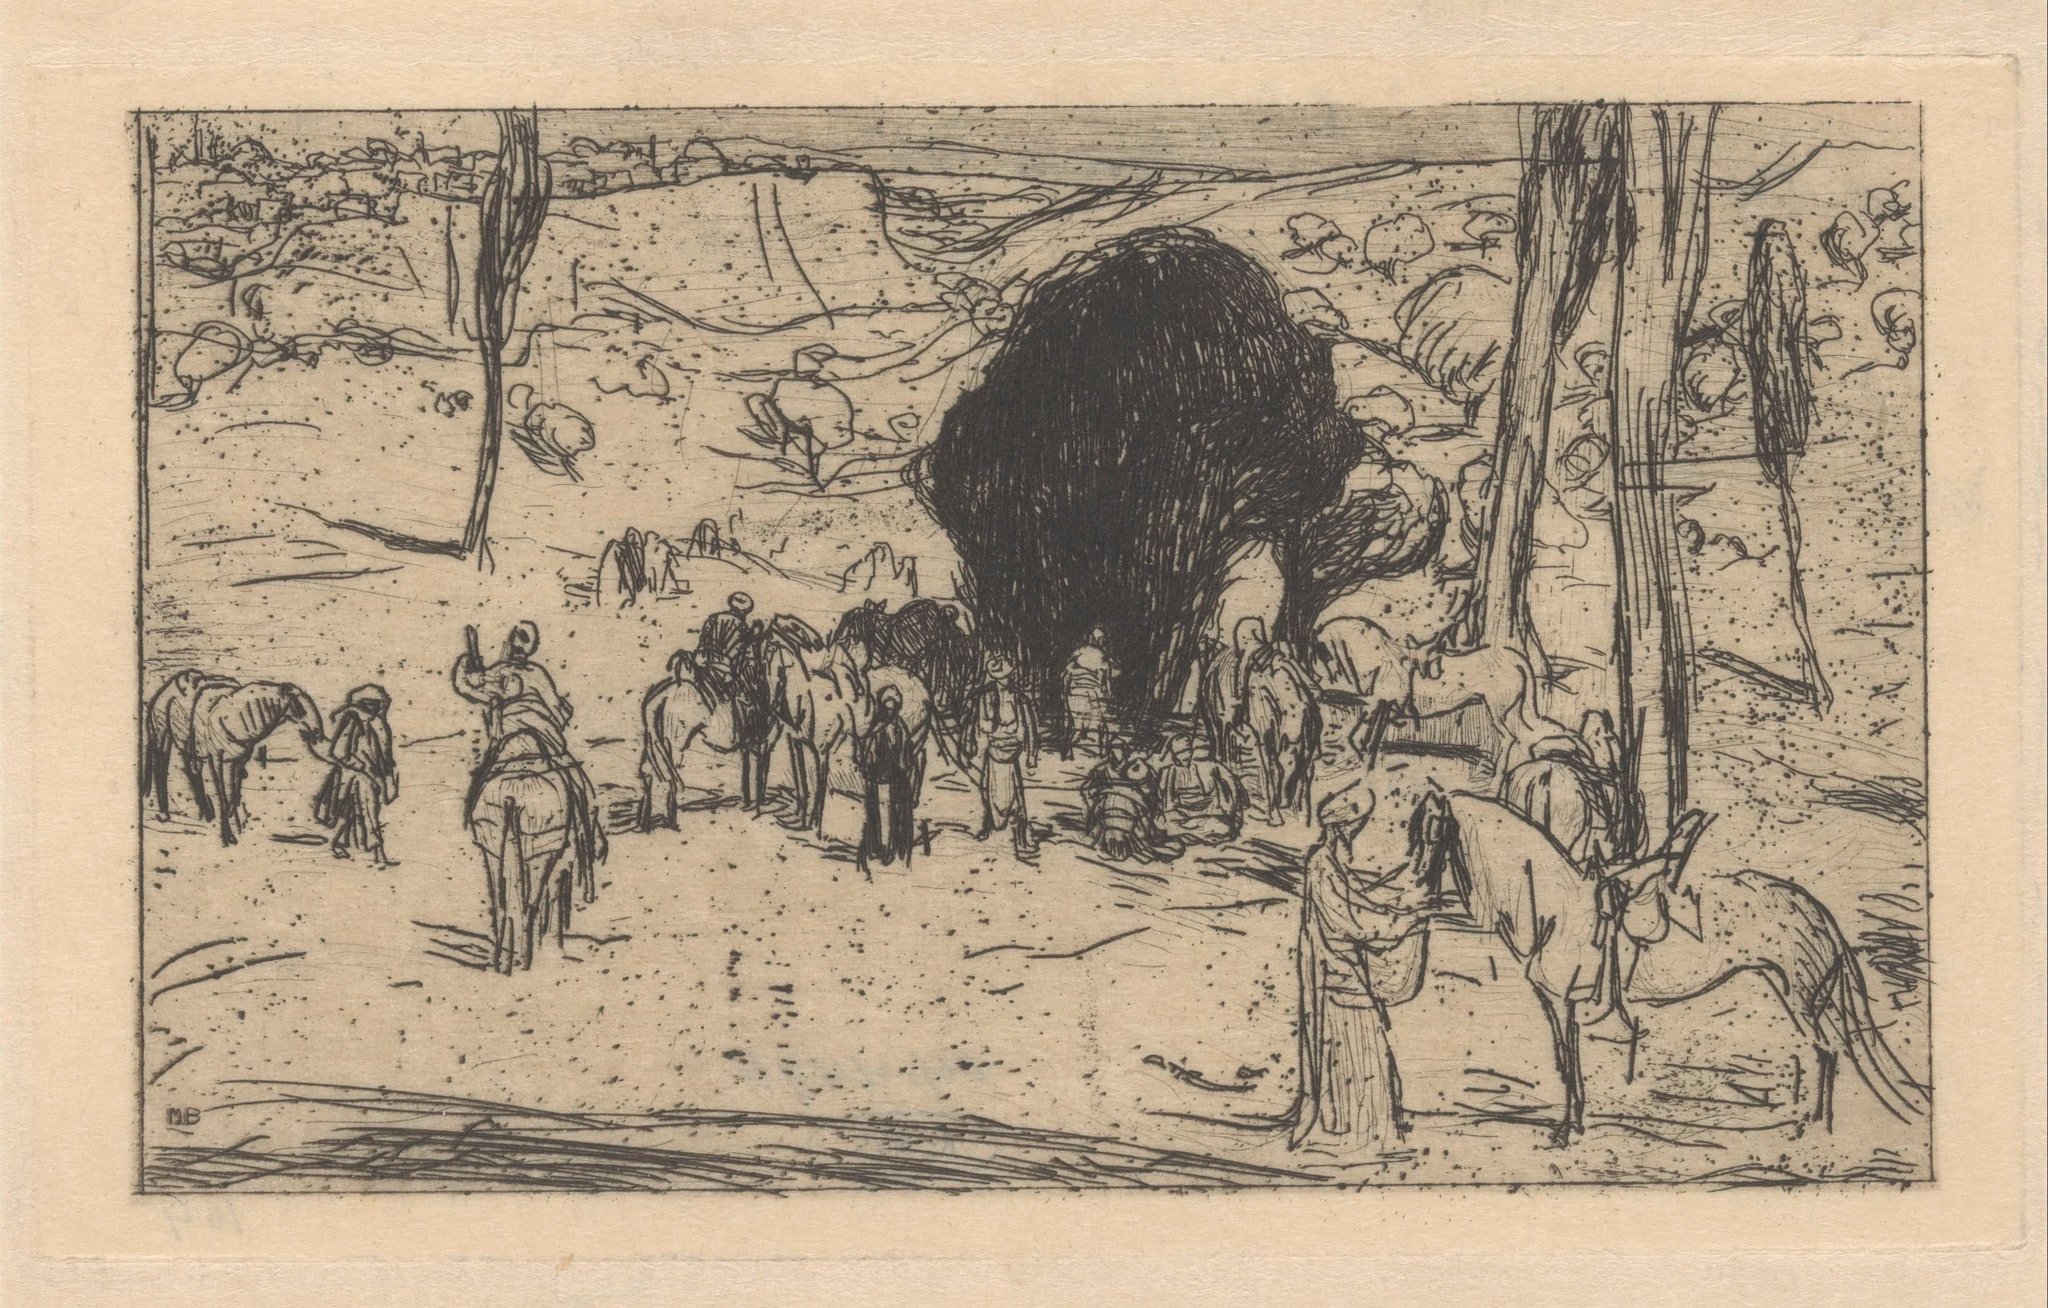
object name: print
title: Ruiterij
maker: marius bauer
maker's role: draughtsman, print maker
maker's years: 1867-1932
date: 1889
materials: paper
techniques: etching, intaglio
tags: riding a horse, ass, or mule; rider, horseman, low hill country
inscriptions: collector's mark: Lugt 2228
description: Een heuvelachtig landschap met een groep mannen en hun opgetuigde paarden. Links op de achtergrond een stad.